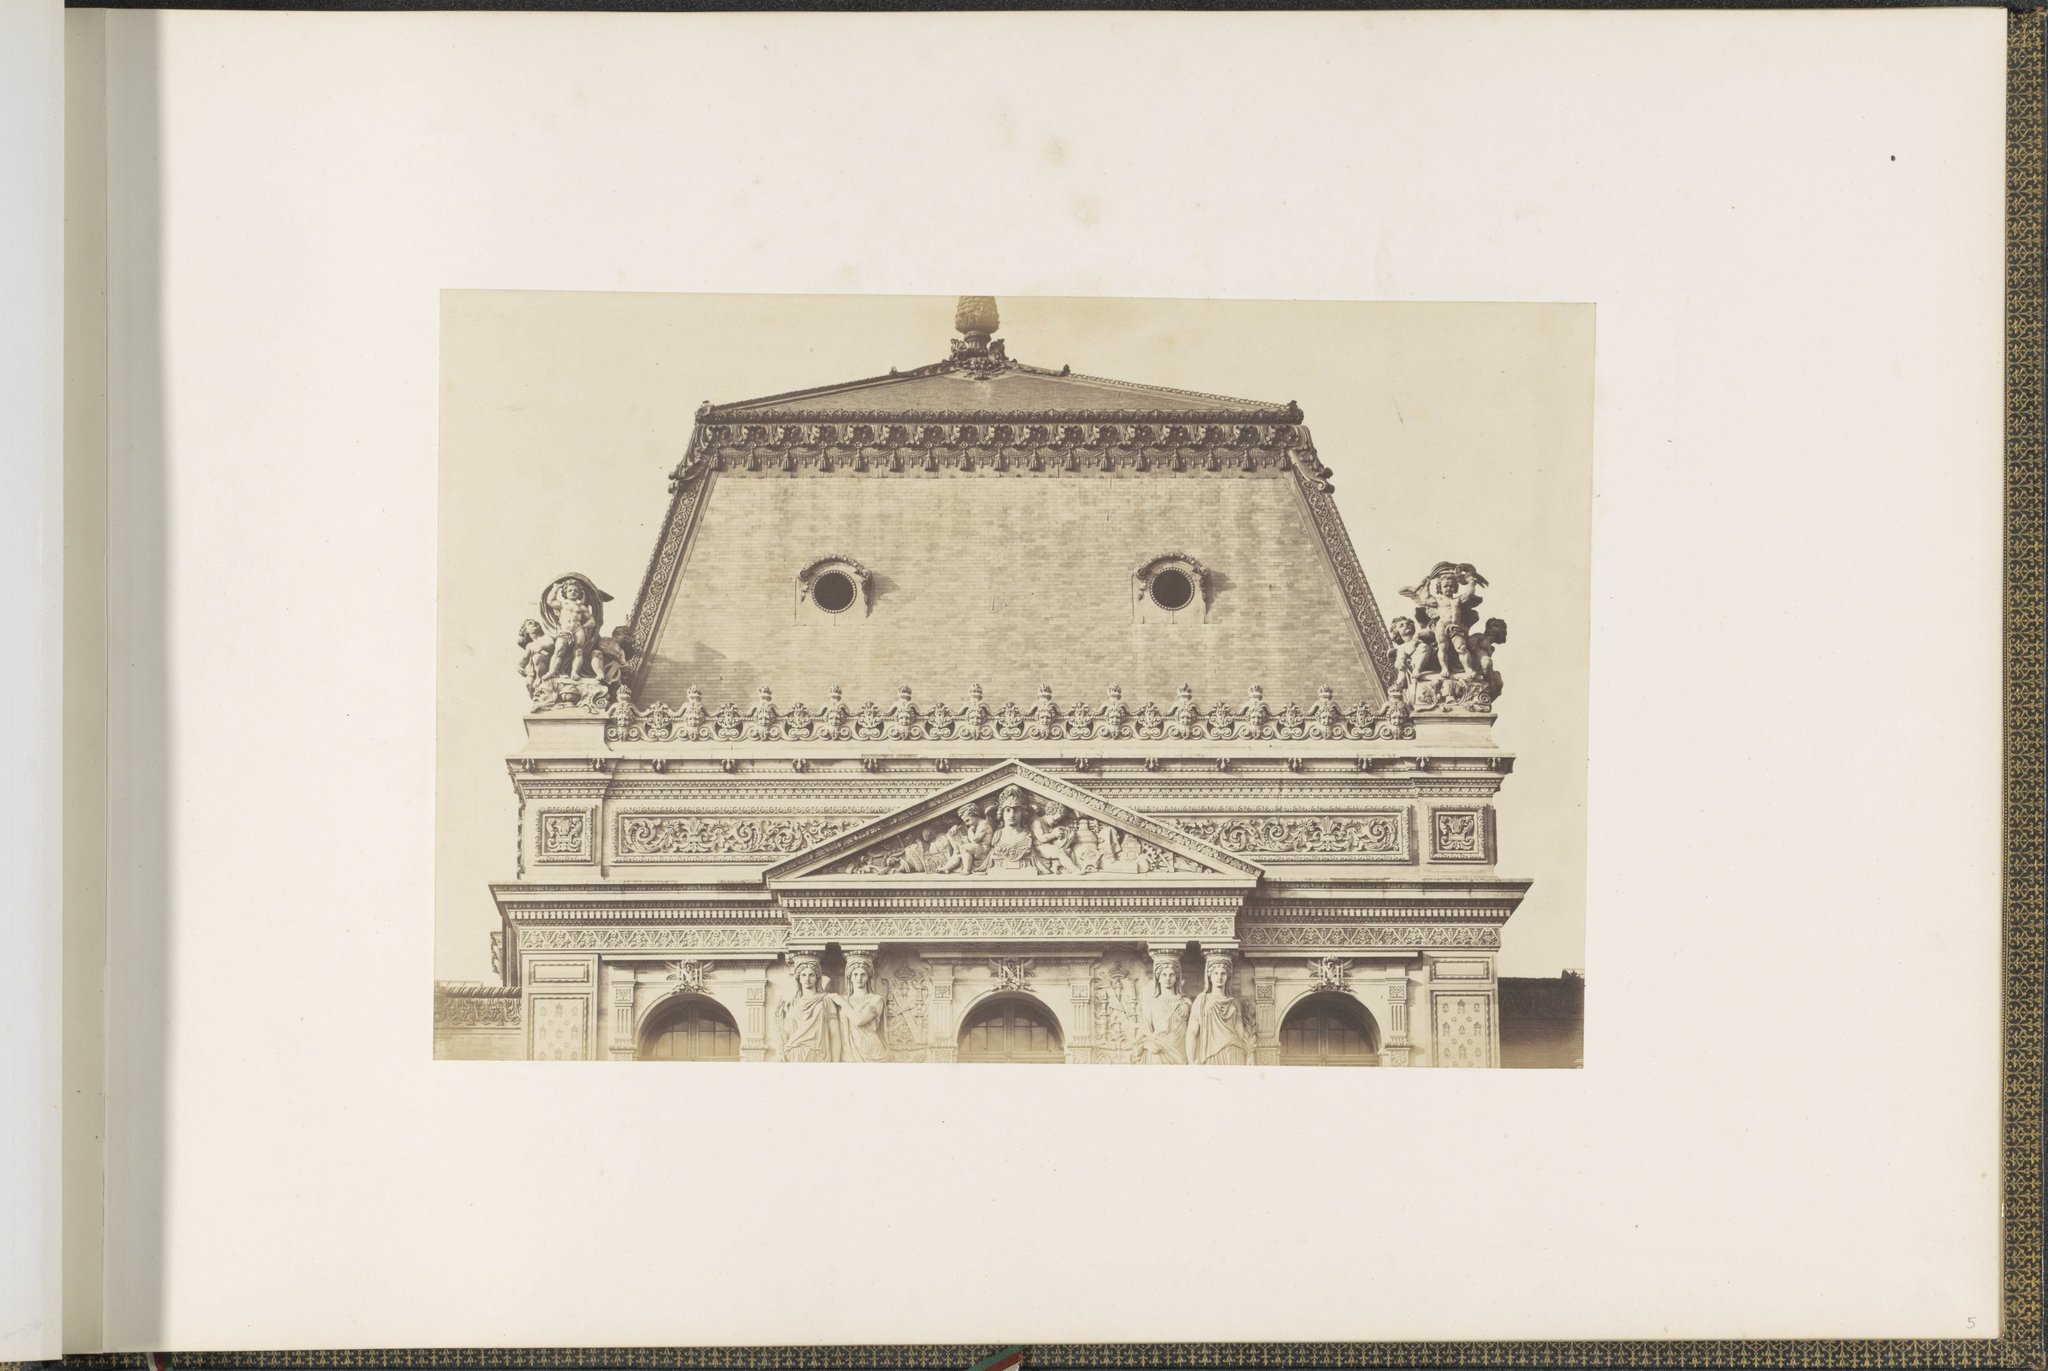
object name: photograph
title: Dak en zolderverdieping van de Bibliothèque Impériale in het Palais du Louvre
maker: édouard denis baldus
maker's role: fotograaf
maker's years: 1813-1889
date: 1857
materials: paper, photographic support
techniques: salted paper print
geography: paris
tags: other architectural details (with name), permanent exhibition, museum, façade (of house or building), paris, tuileries palace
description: Onderdeel van Réunion des Tuileries au Louvre 1852-1857, album 4.